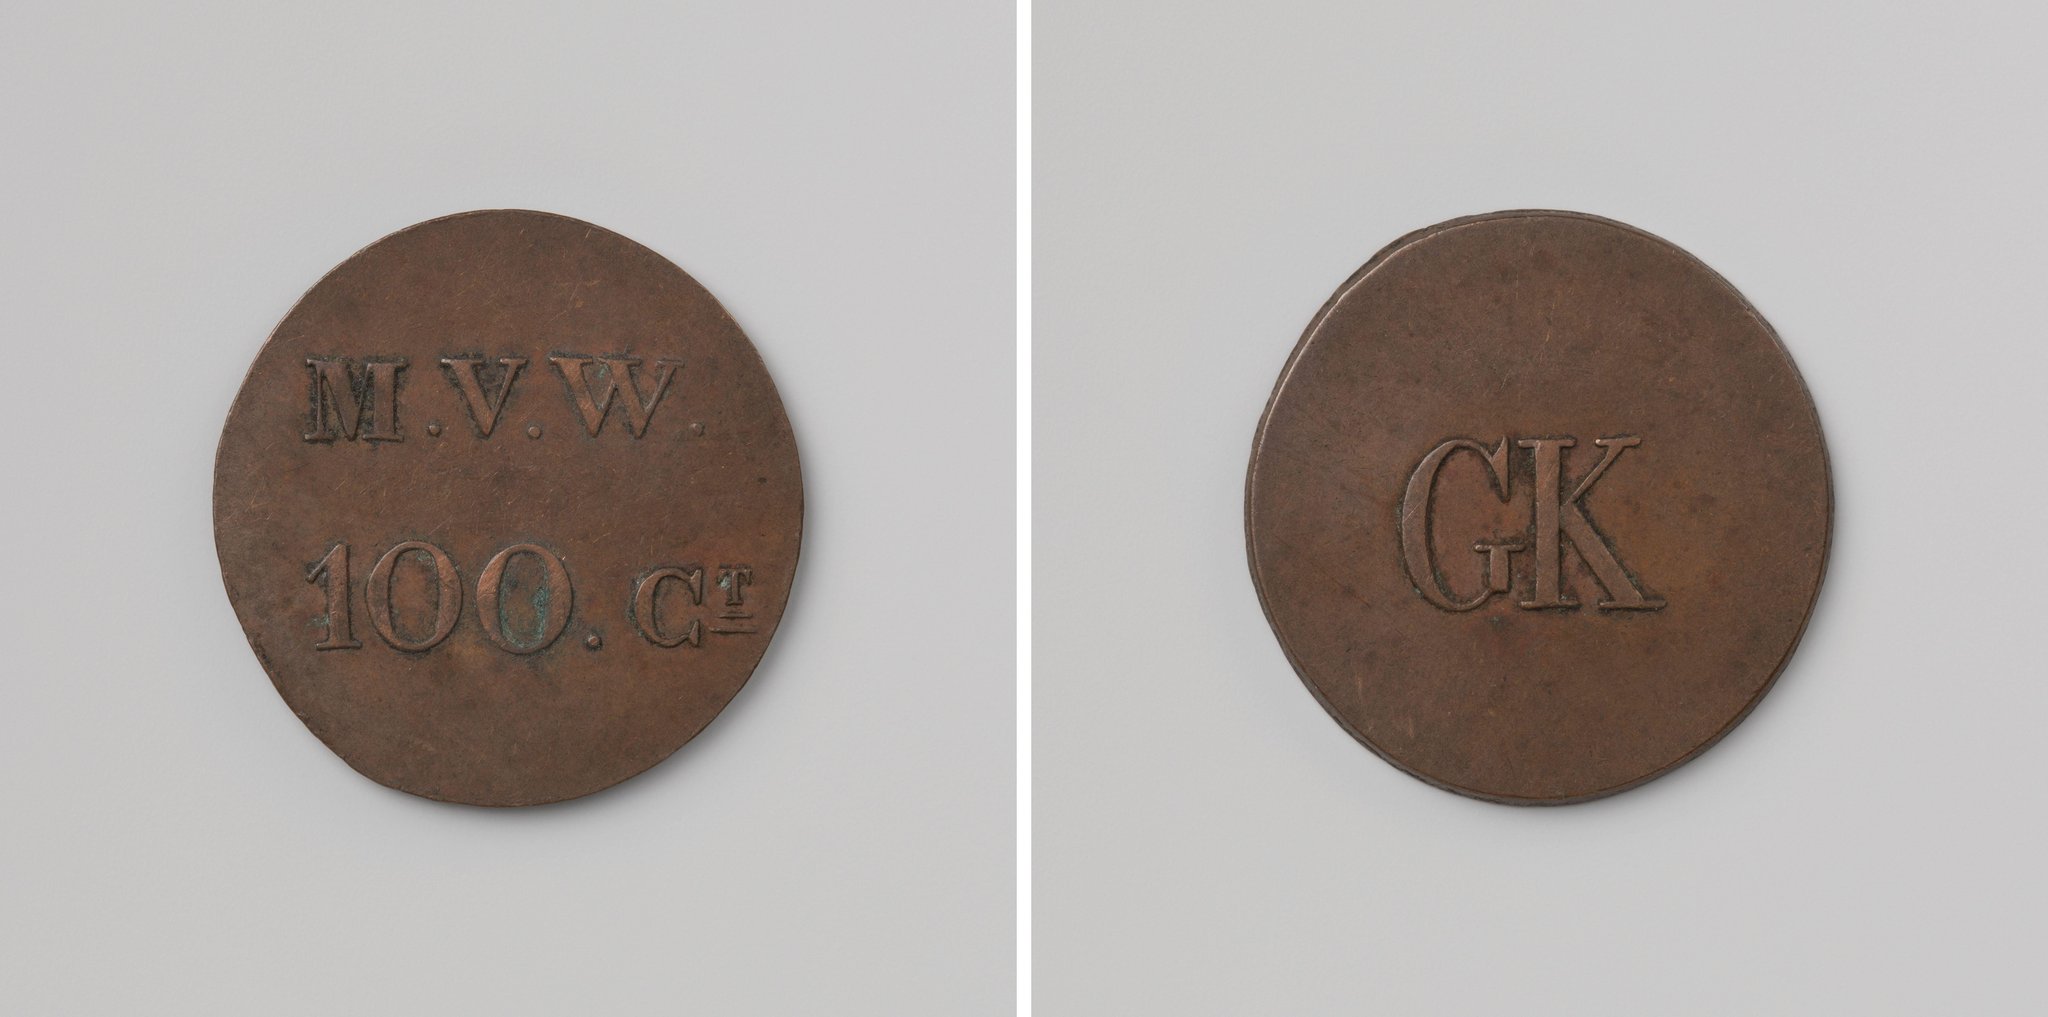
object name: huismunt prison money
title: Huismunt geslagen op last van de Maatschappij van Weldadigheid ter waarde van 1 gulden, ten behoeve van de Gewone Koloniën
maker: Anonymous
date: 1818-1859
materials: copper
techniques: striking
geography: netherlands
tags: maatschappij van weldadigheid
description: Voorzijde: opschrift boven waardeaanduiding. Keerzijde: letters G en K